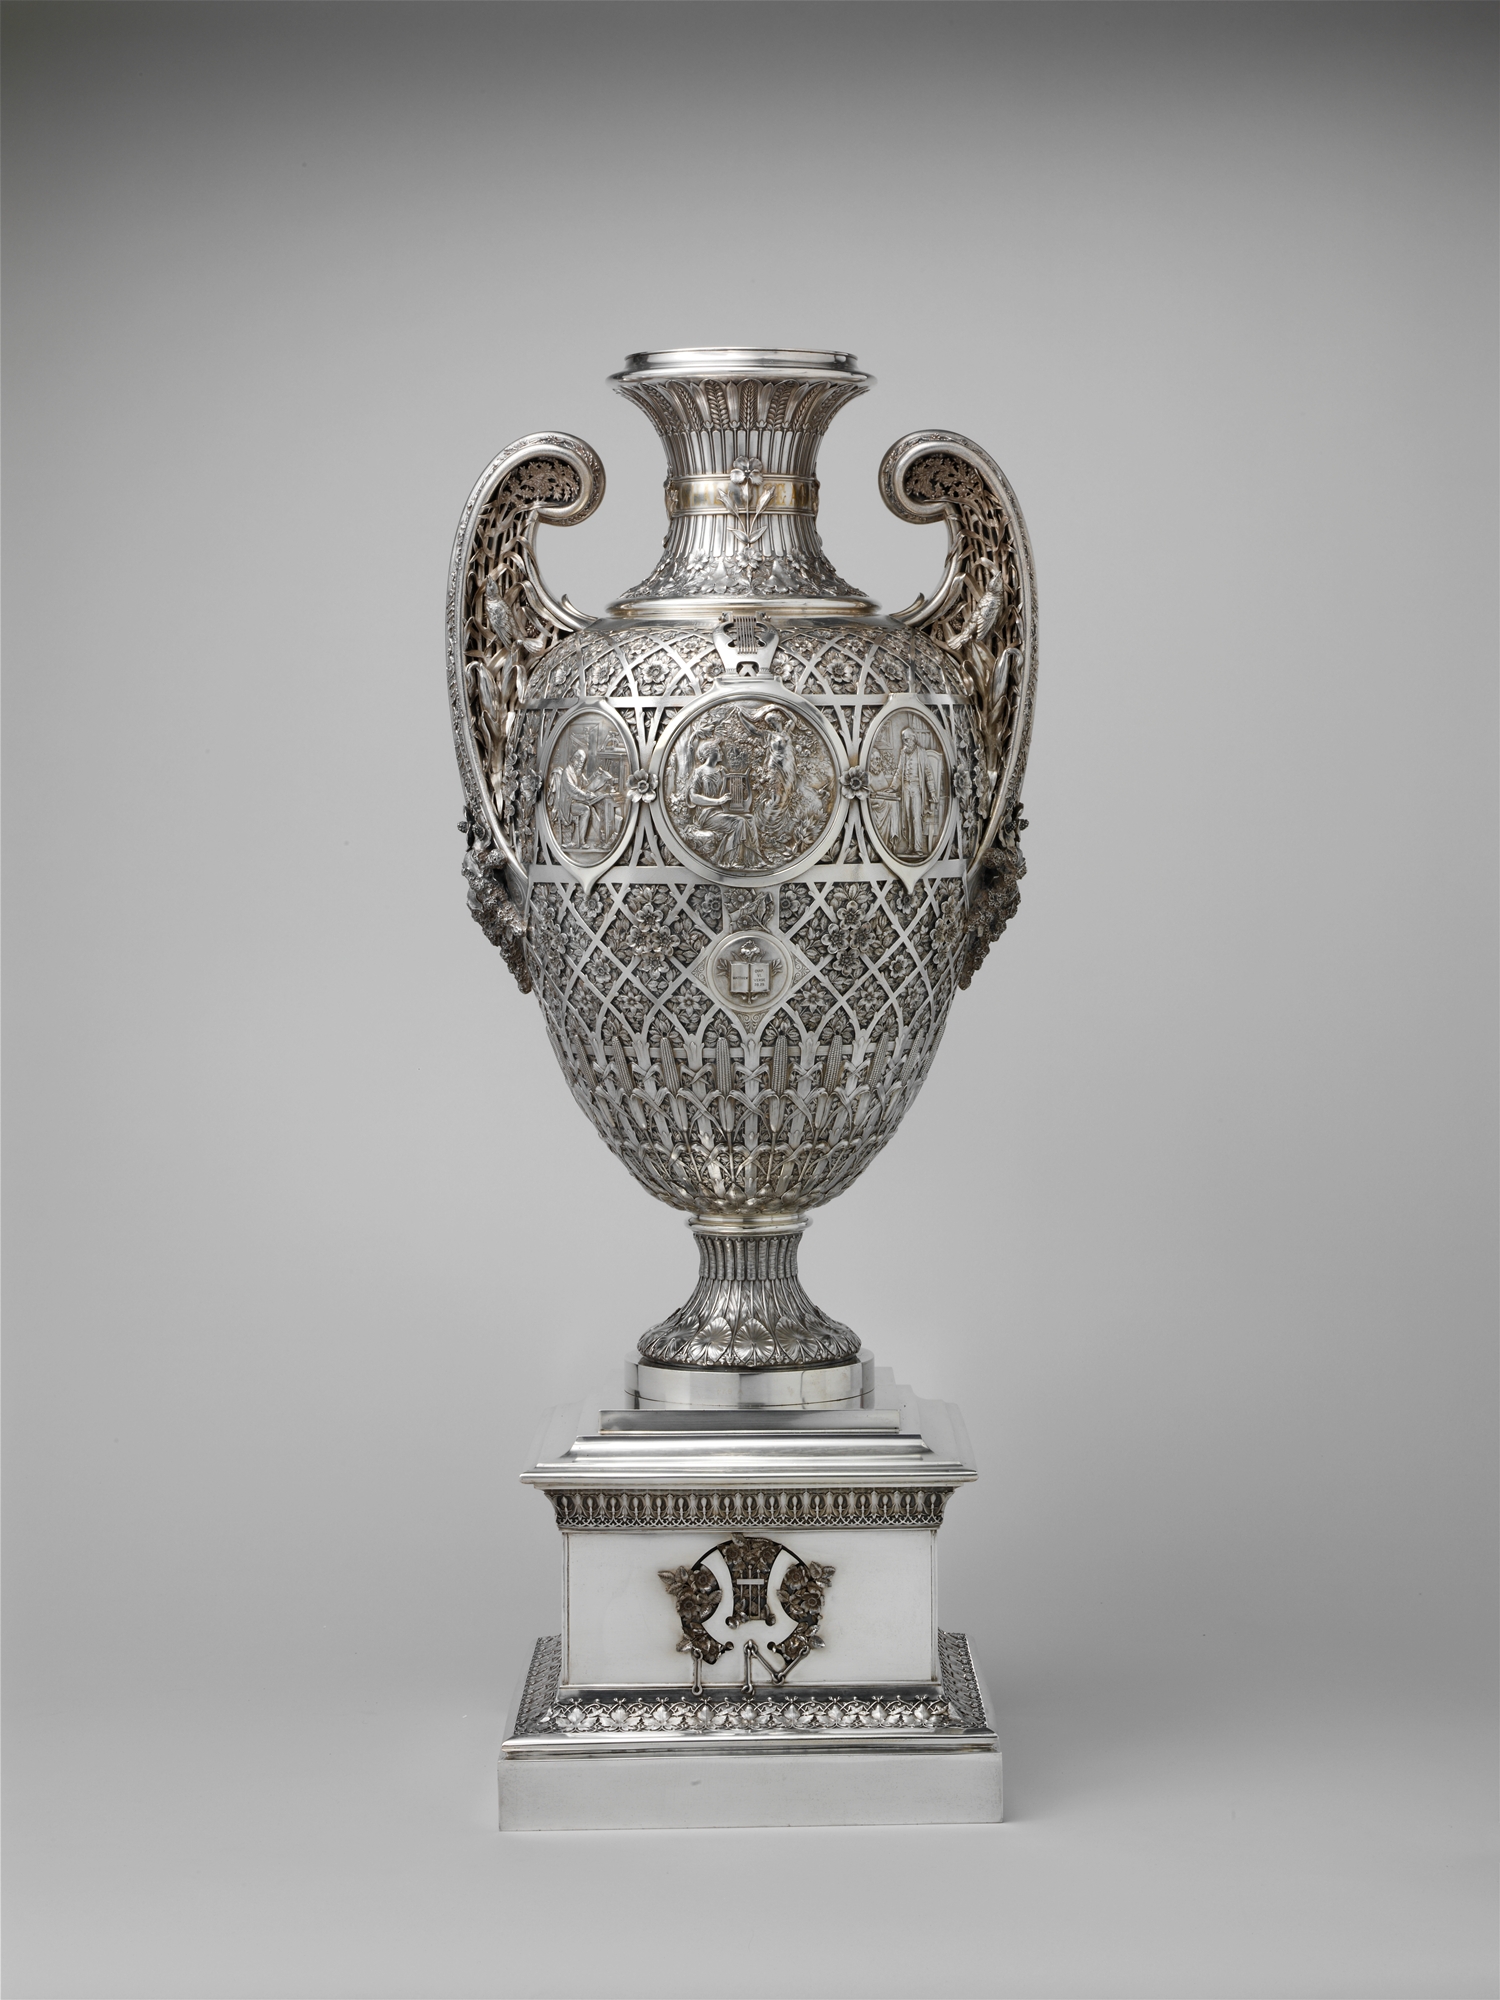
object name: vase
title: The Bryant Vase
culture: american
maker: tiffany & co.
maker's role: manufacturer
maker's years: 1837-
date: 1876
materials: gold, silver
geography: united states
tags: musical instruments,birds,men,women,flowers